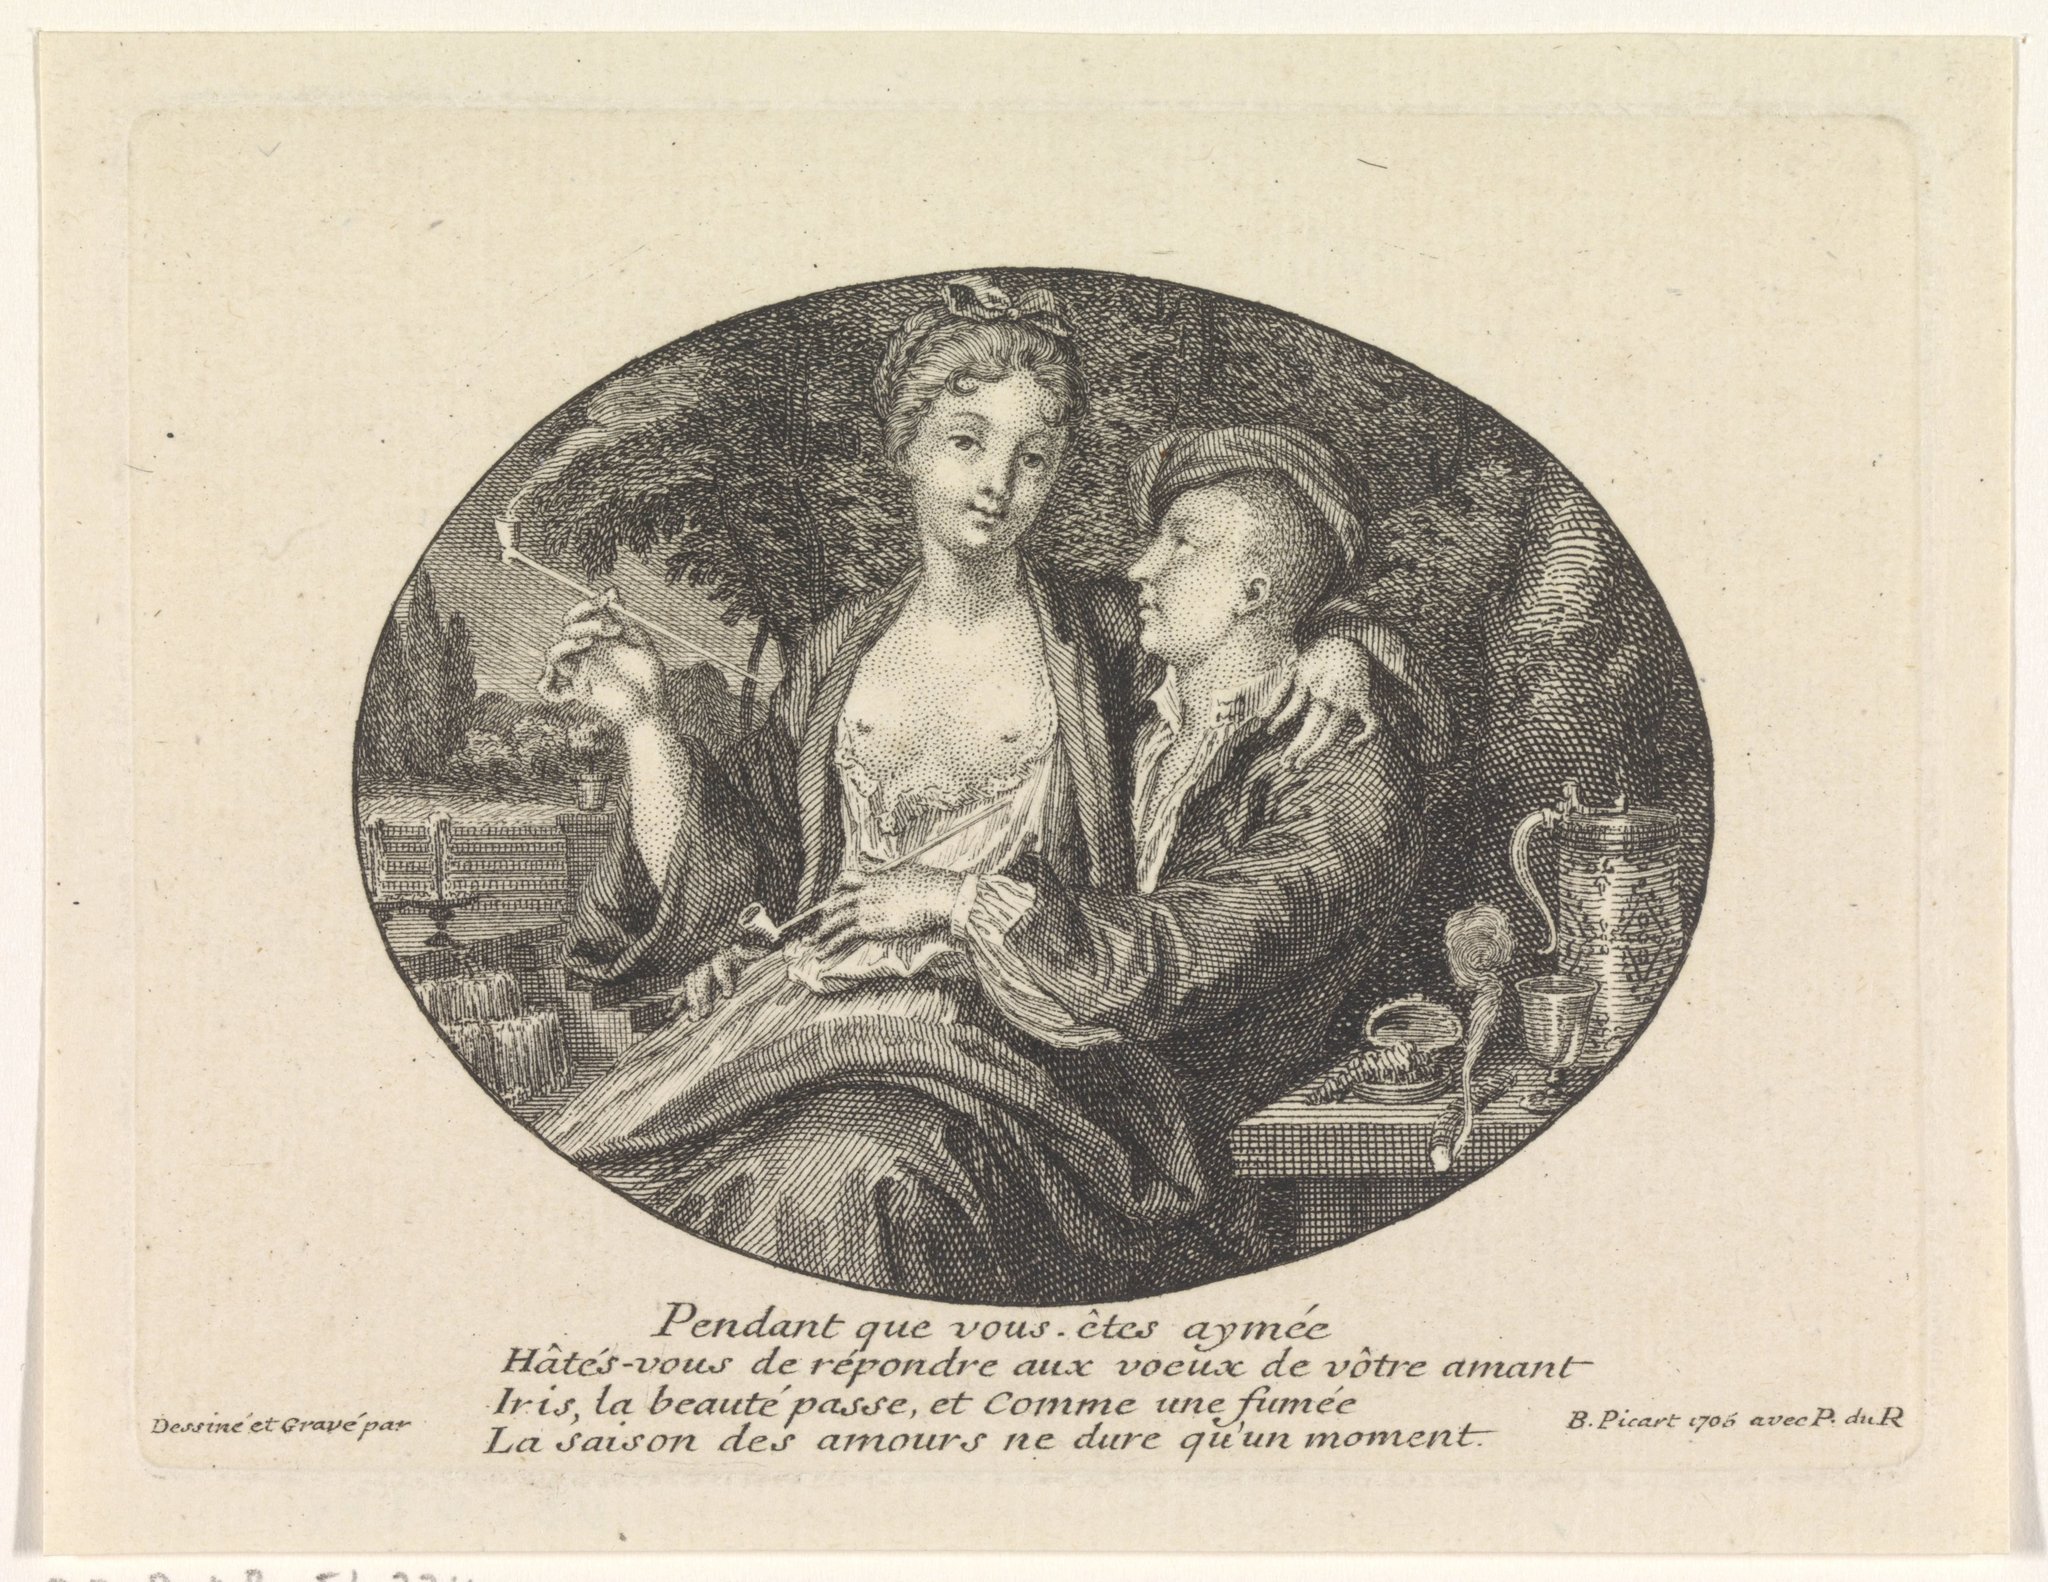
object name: print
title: Paar dat een pijp rookt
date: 1706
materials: paper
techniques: engraving, etching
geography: paris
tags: pipe ~ tobacco, whore, prostitute, lovers; courting, flirting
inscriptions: collector's mark: Lugt 2228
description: Een vrouw zit bij een man op schoot. Zij draagt een jurk die haar borsten onbedekt laat. Samen roken ze een pijp. In de marge een vierregelig onderschrift in het Frans dat waarschuwt voor betaalde liefde: die liefde is zo voorbij.